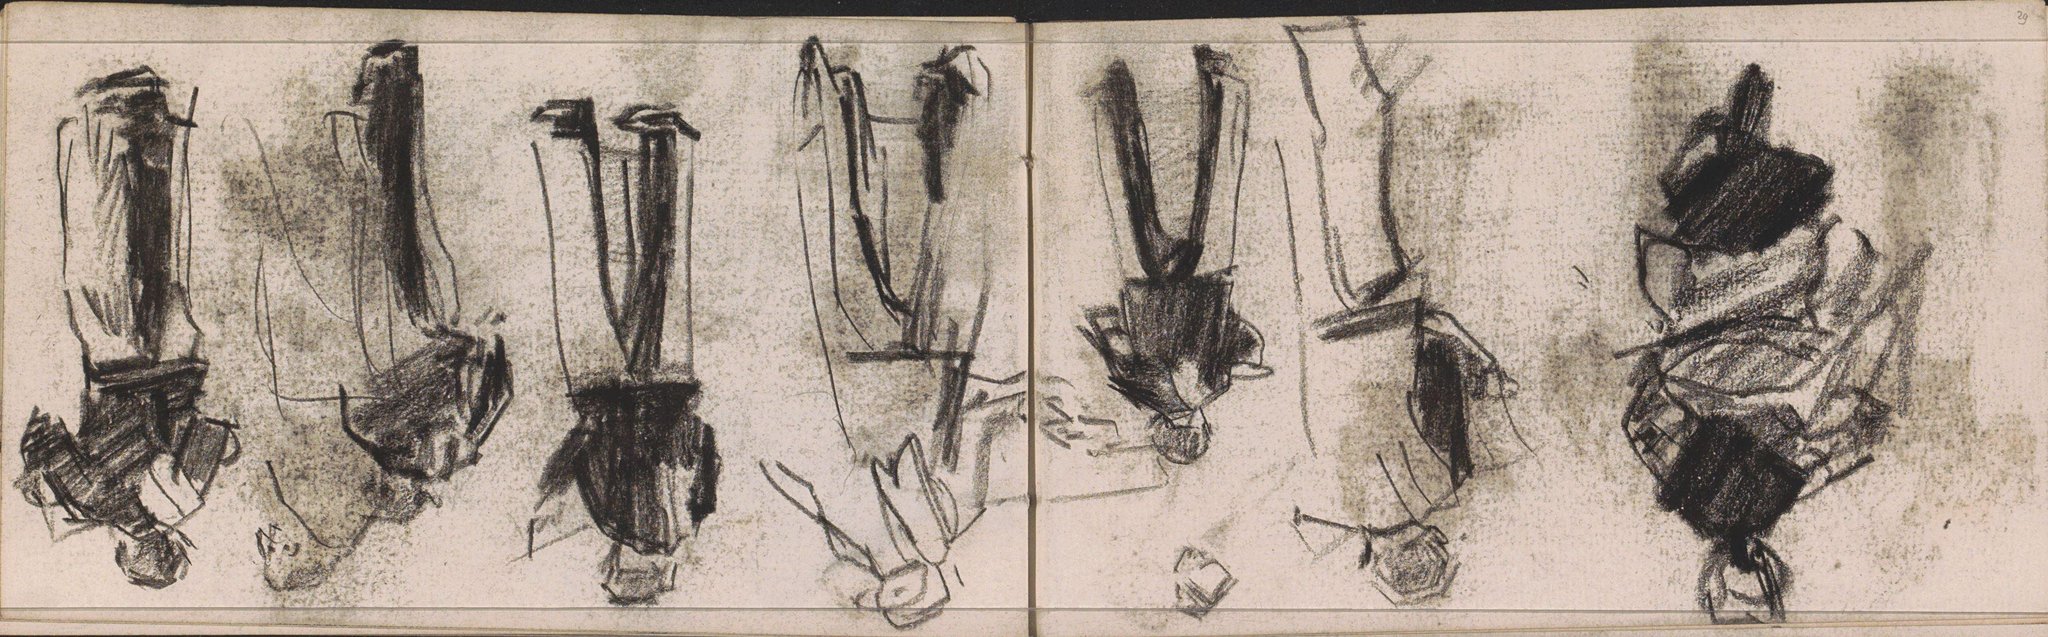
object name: sketchbook leaf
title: Staande mannen, op de rug gezien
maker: isaac israels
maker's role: draughtsman, painter, print maker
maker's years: 1865-1934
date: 1875-1934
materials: chalk, paper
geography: the hague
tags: kitchen-personnel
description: Mogelijk obers of keukenpersoneel. Over de schouder een doek. Pagina 28 en pagina 29 uit schetsboek XLVIII met 62 pagina's.